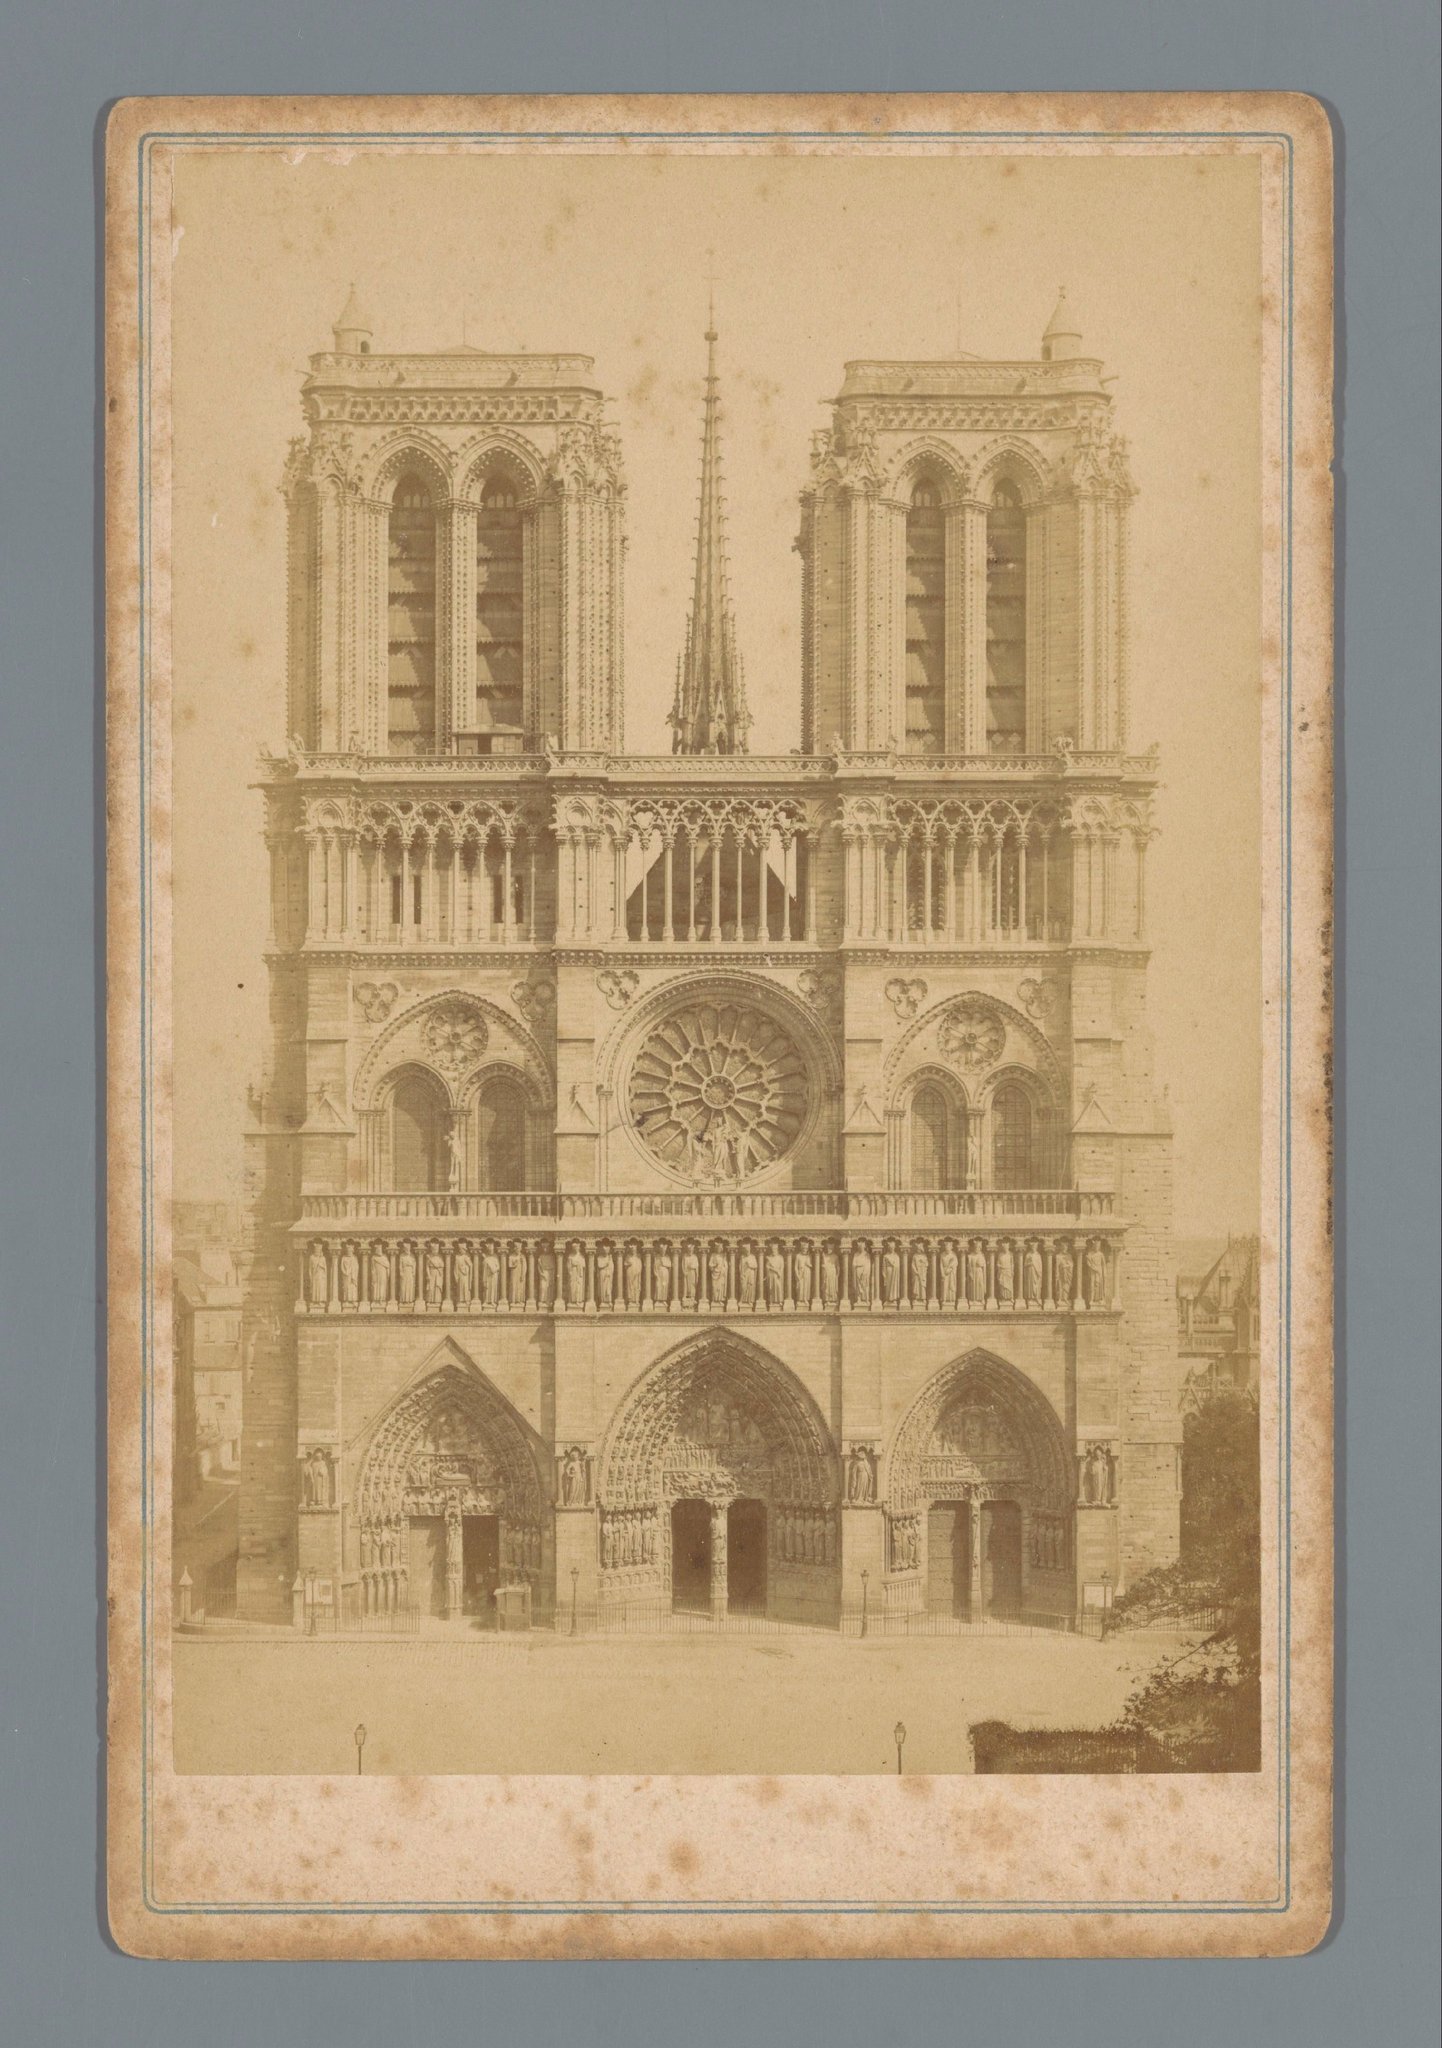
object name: cabinet photograph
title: Notre-Dame te Parijs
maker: Anonymous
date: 1860-1890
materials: cardboard, photographic support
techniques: albumen print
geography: paris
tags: church (exterior), façade (of house or building)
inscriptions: annotation: ‘Notre Dame’